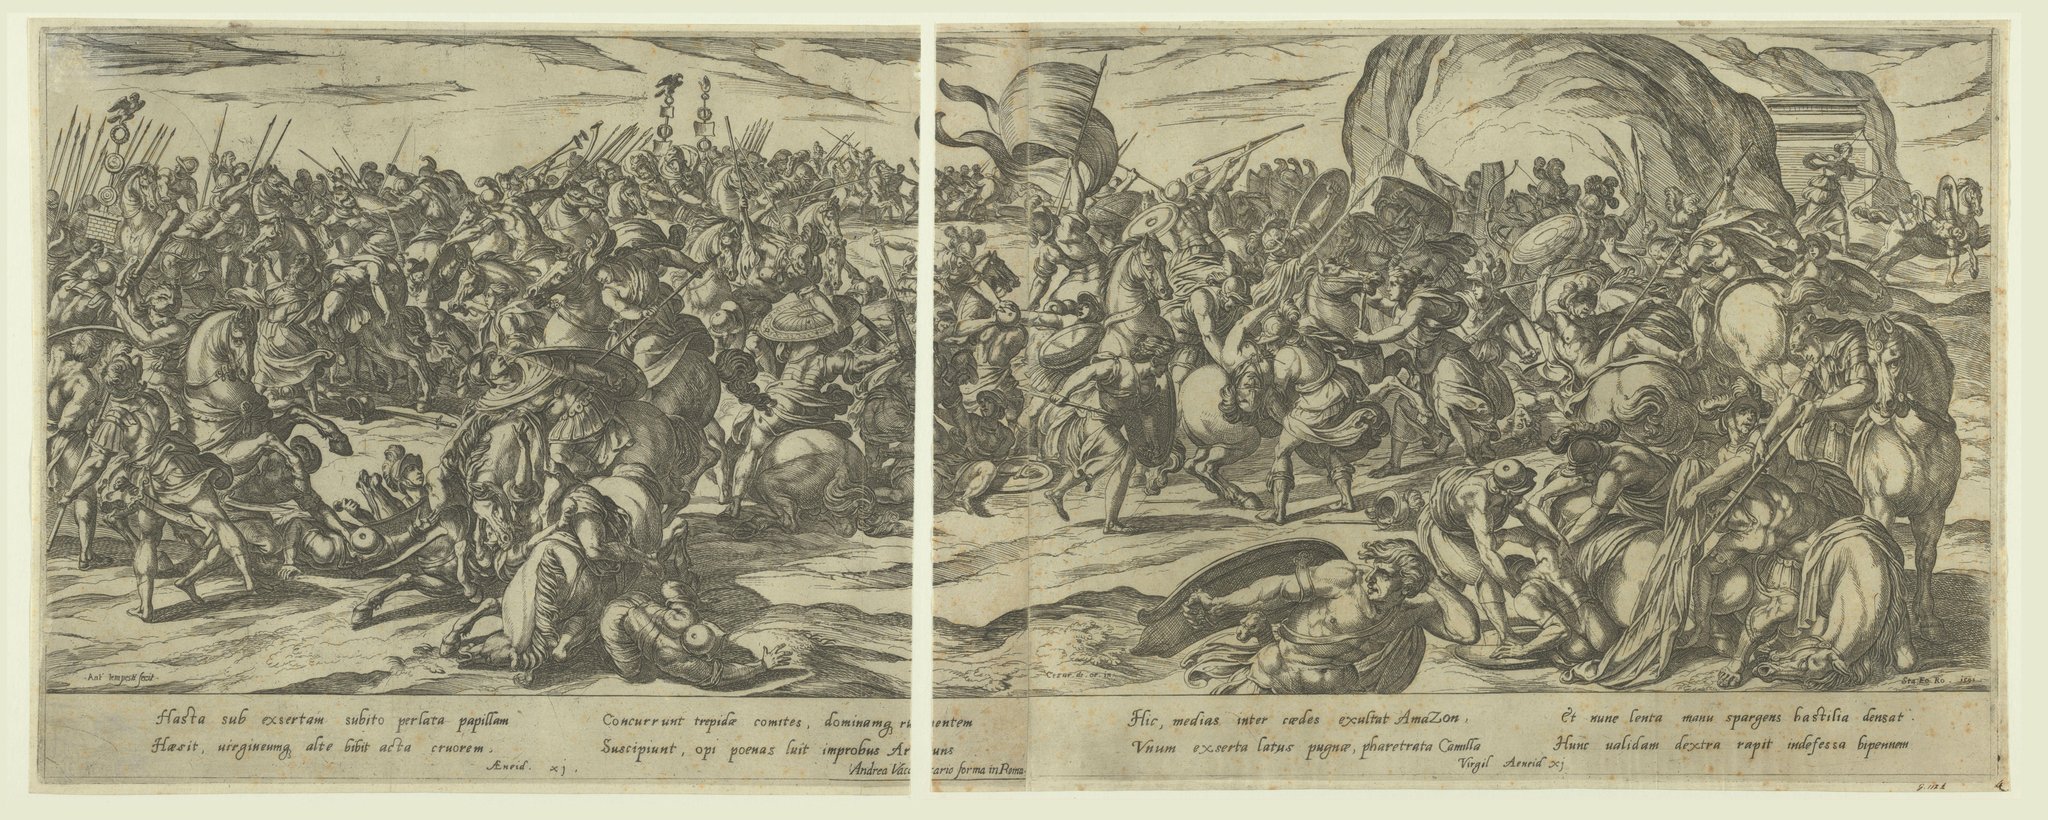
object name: print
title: De dood van Camillus in de strijd tussen Grieken en Romeinen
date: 1591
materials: paper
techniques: etching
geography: rome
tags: (story of) camilla - death, battle, the soldier; the soldier's life, warfare; military affairs (+ land forces)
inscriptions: number: ‘4’, collector's mark: ‘Hinloopen’, collector's mark: Lugt 11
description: De dood van Camillus in een strijdgewoel van Griekse en Romeinse soldaten te paard. Vers in het Latijn in ondermarge.